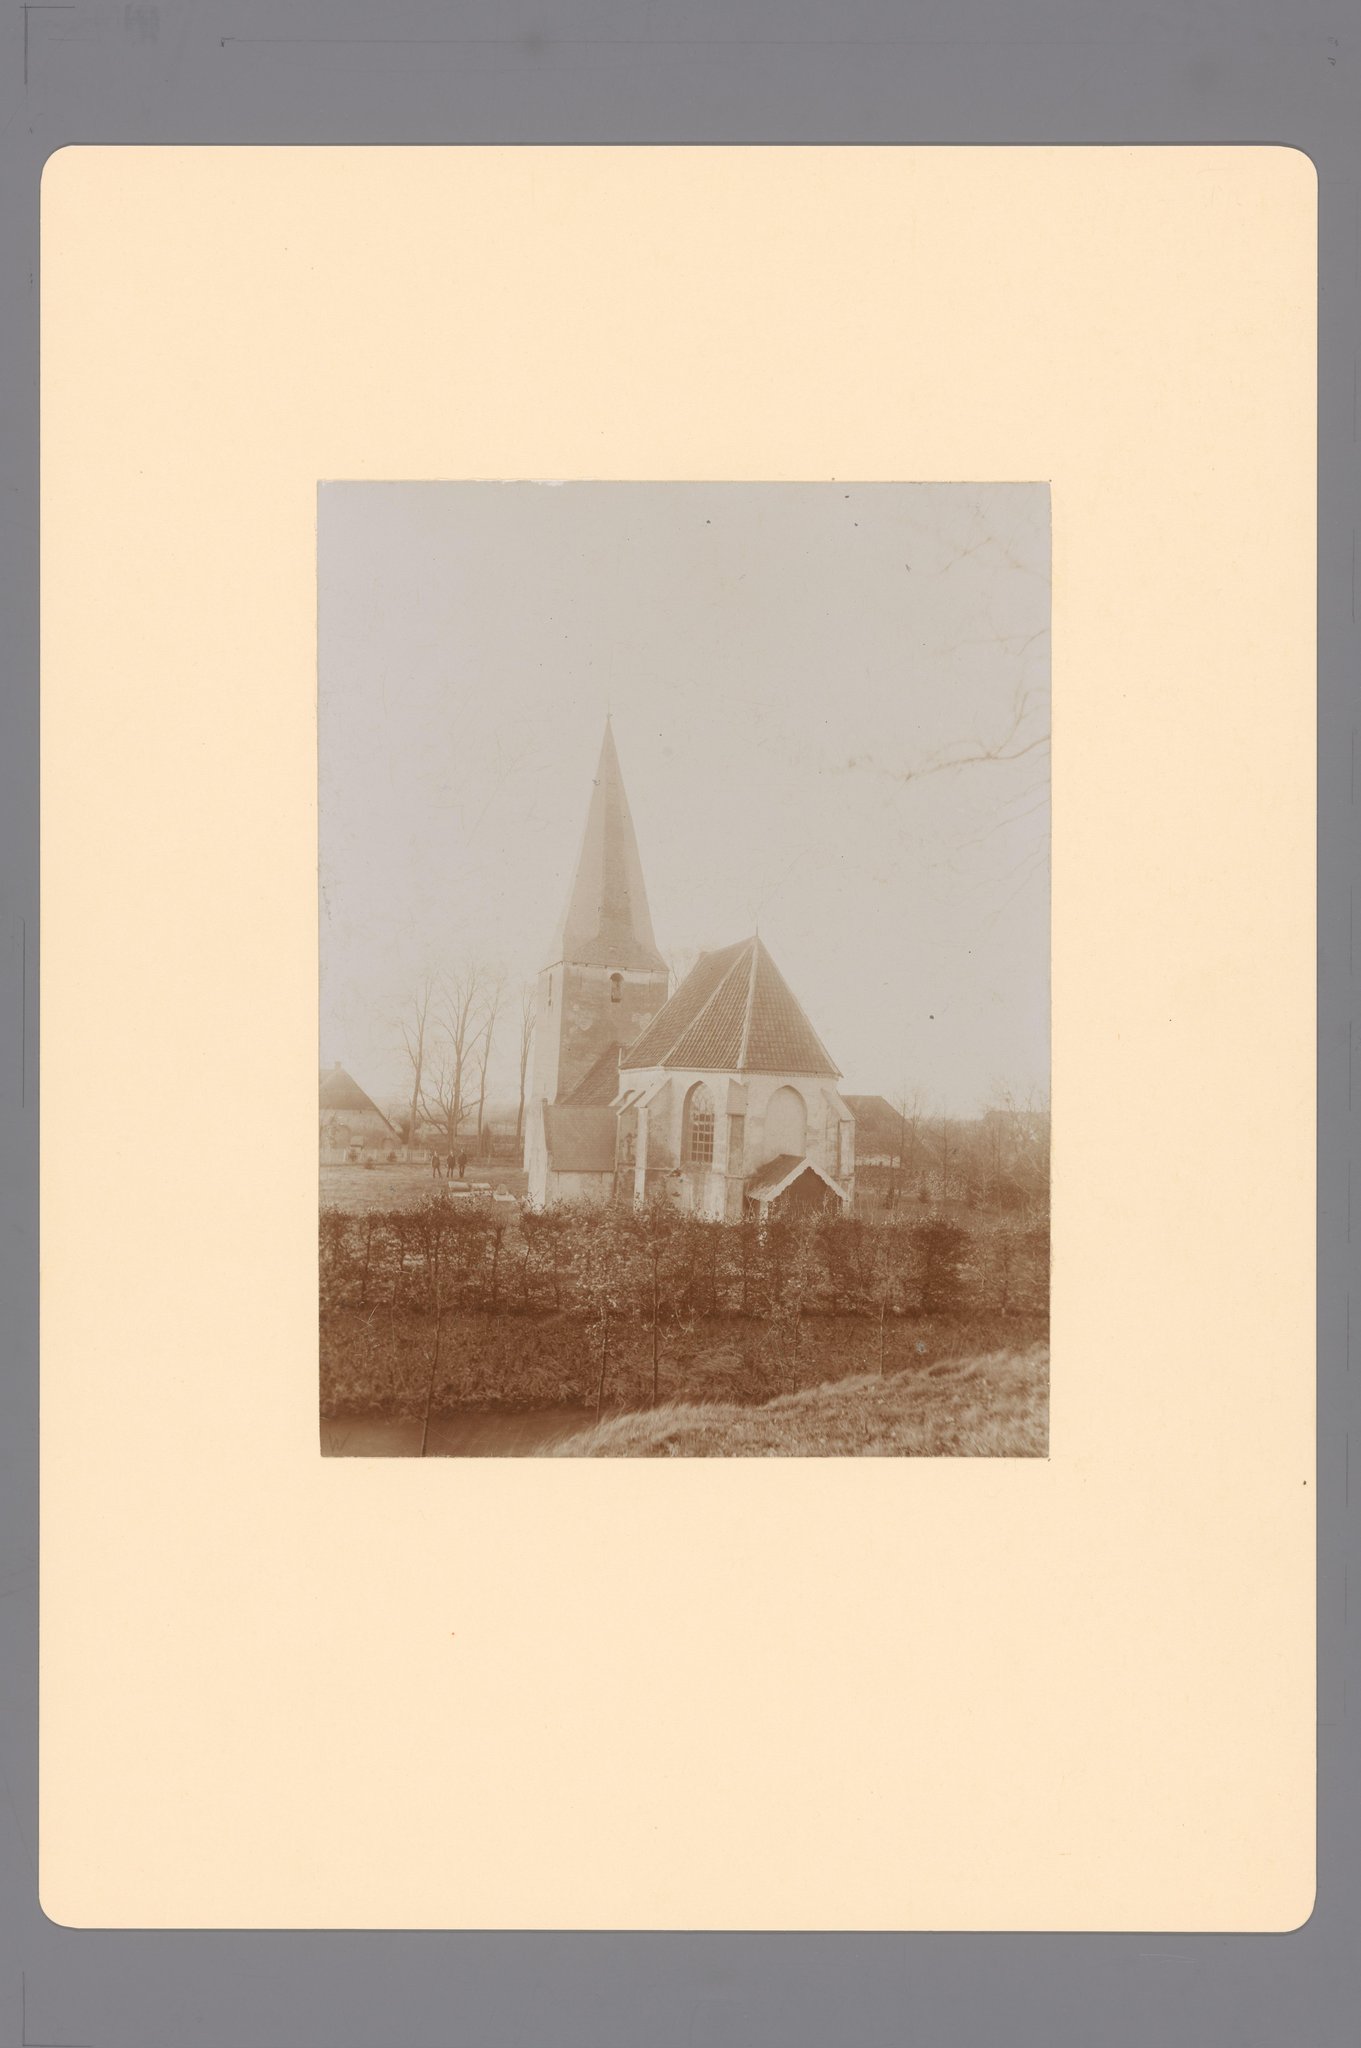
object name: photograph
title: Gezicht op de Hervormde kerk te Leur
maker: anoniem (monumentenzorg)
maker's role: fotograaf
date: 1890-1920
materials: cardboard, photographic support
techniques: collodion silver print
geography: leur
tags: church (exterior), landscapes in the temperate zone (+ landscape with figures, staffage)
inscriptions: annotation: ‘W’, annotation: ‘N.H. Kerk te Leur bij Wijchen (G.)’